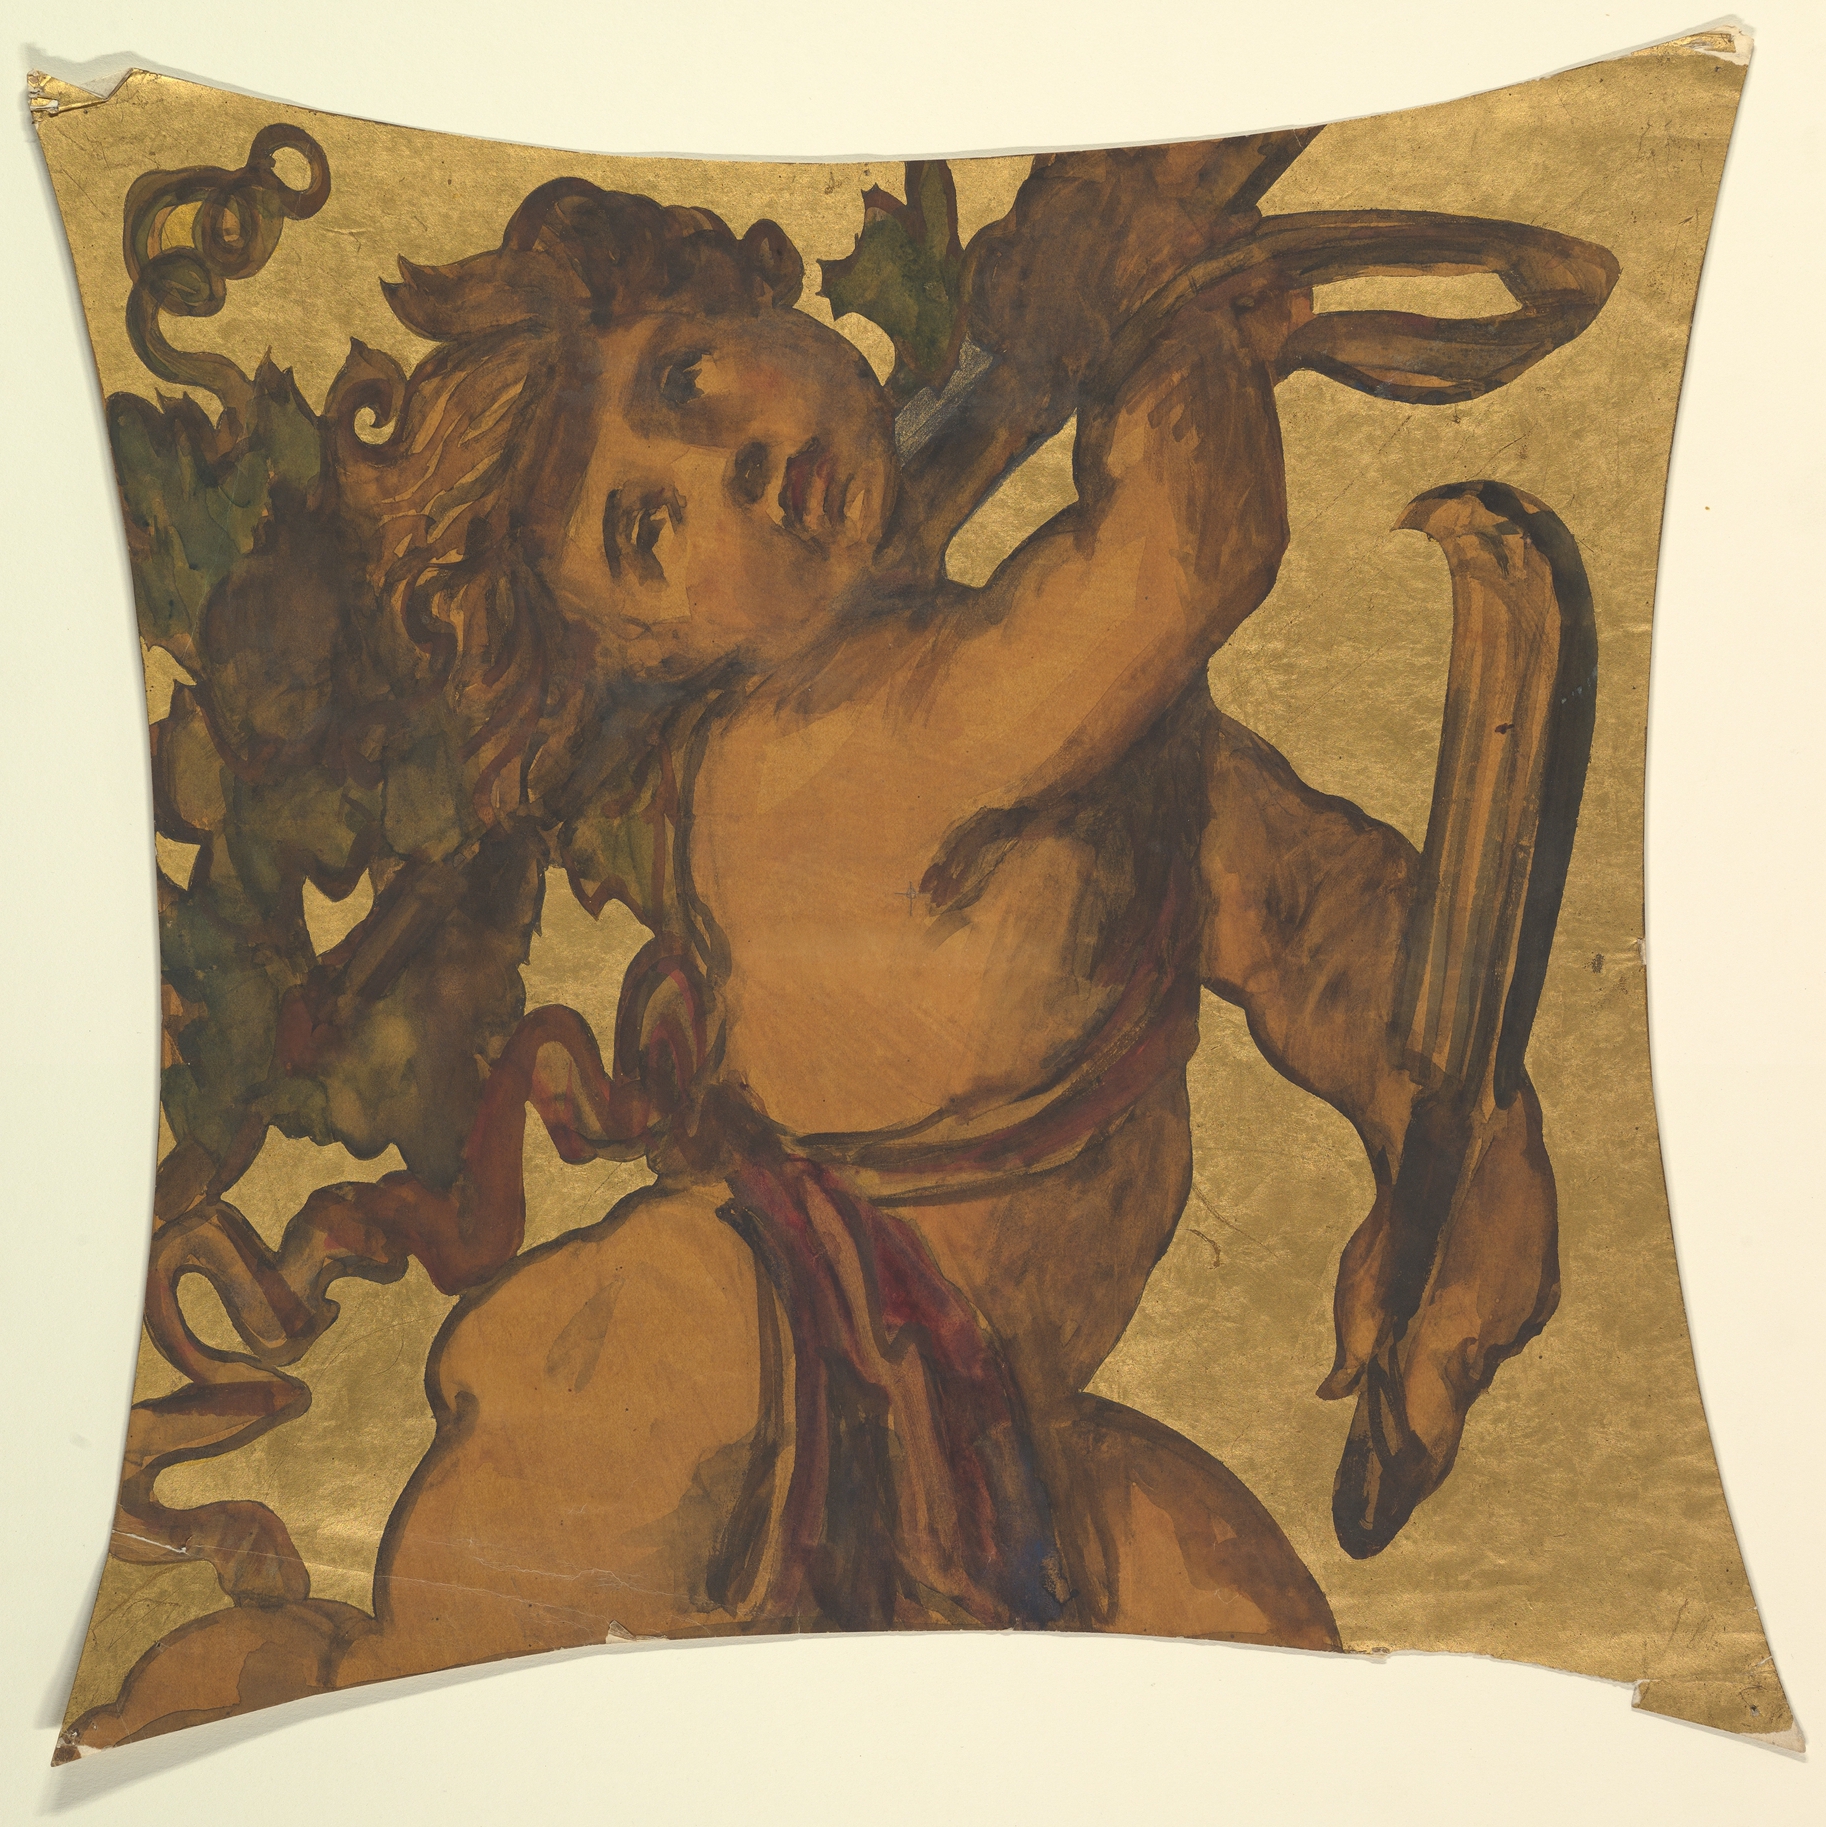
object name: drawing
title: Study for ceiling decoration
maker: anonymous, british, 19th century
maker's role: artist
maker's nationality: british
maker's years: 1800-1900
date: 1801-1900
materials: gold, gouache, pigment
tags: boys